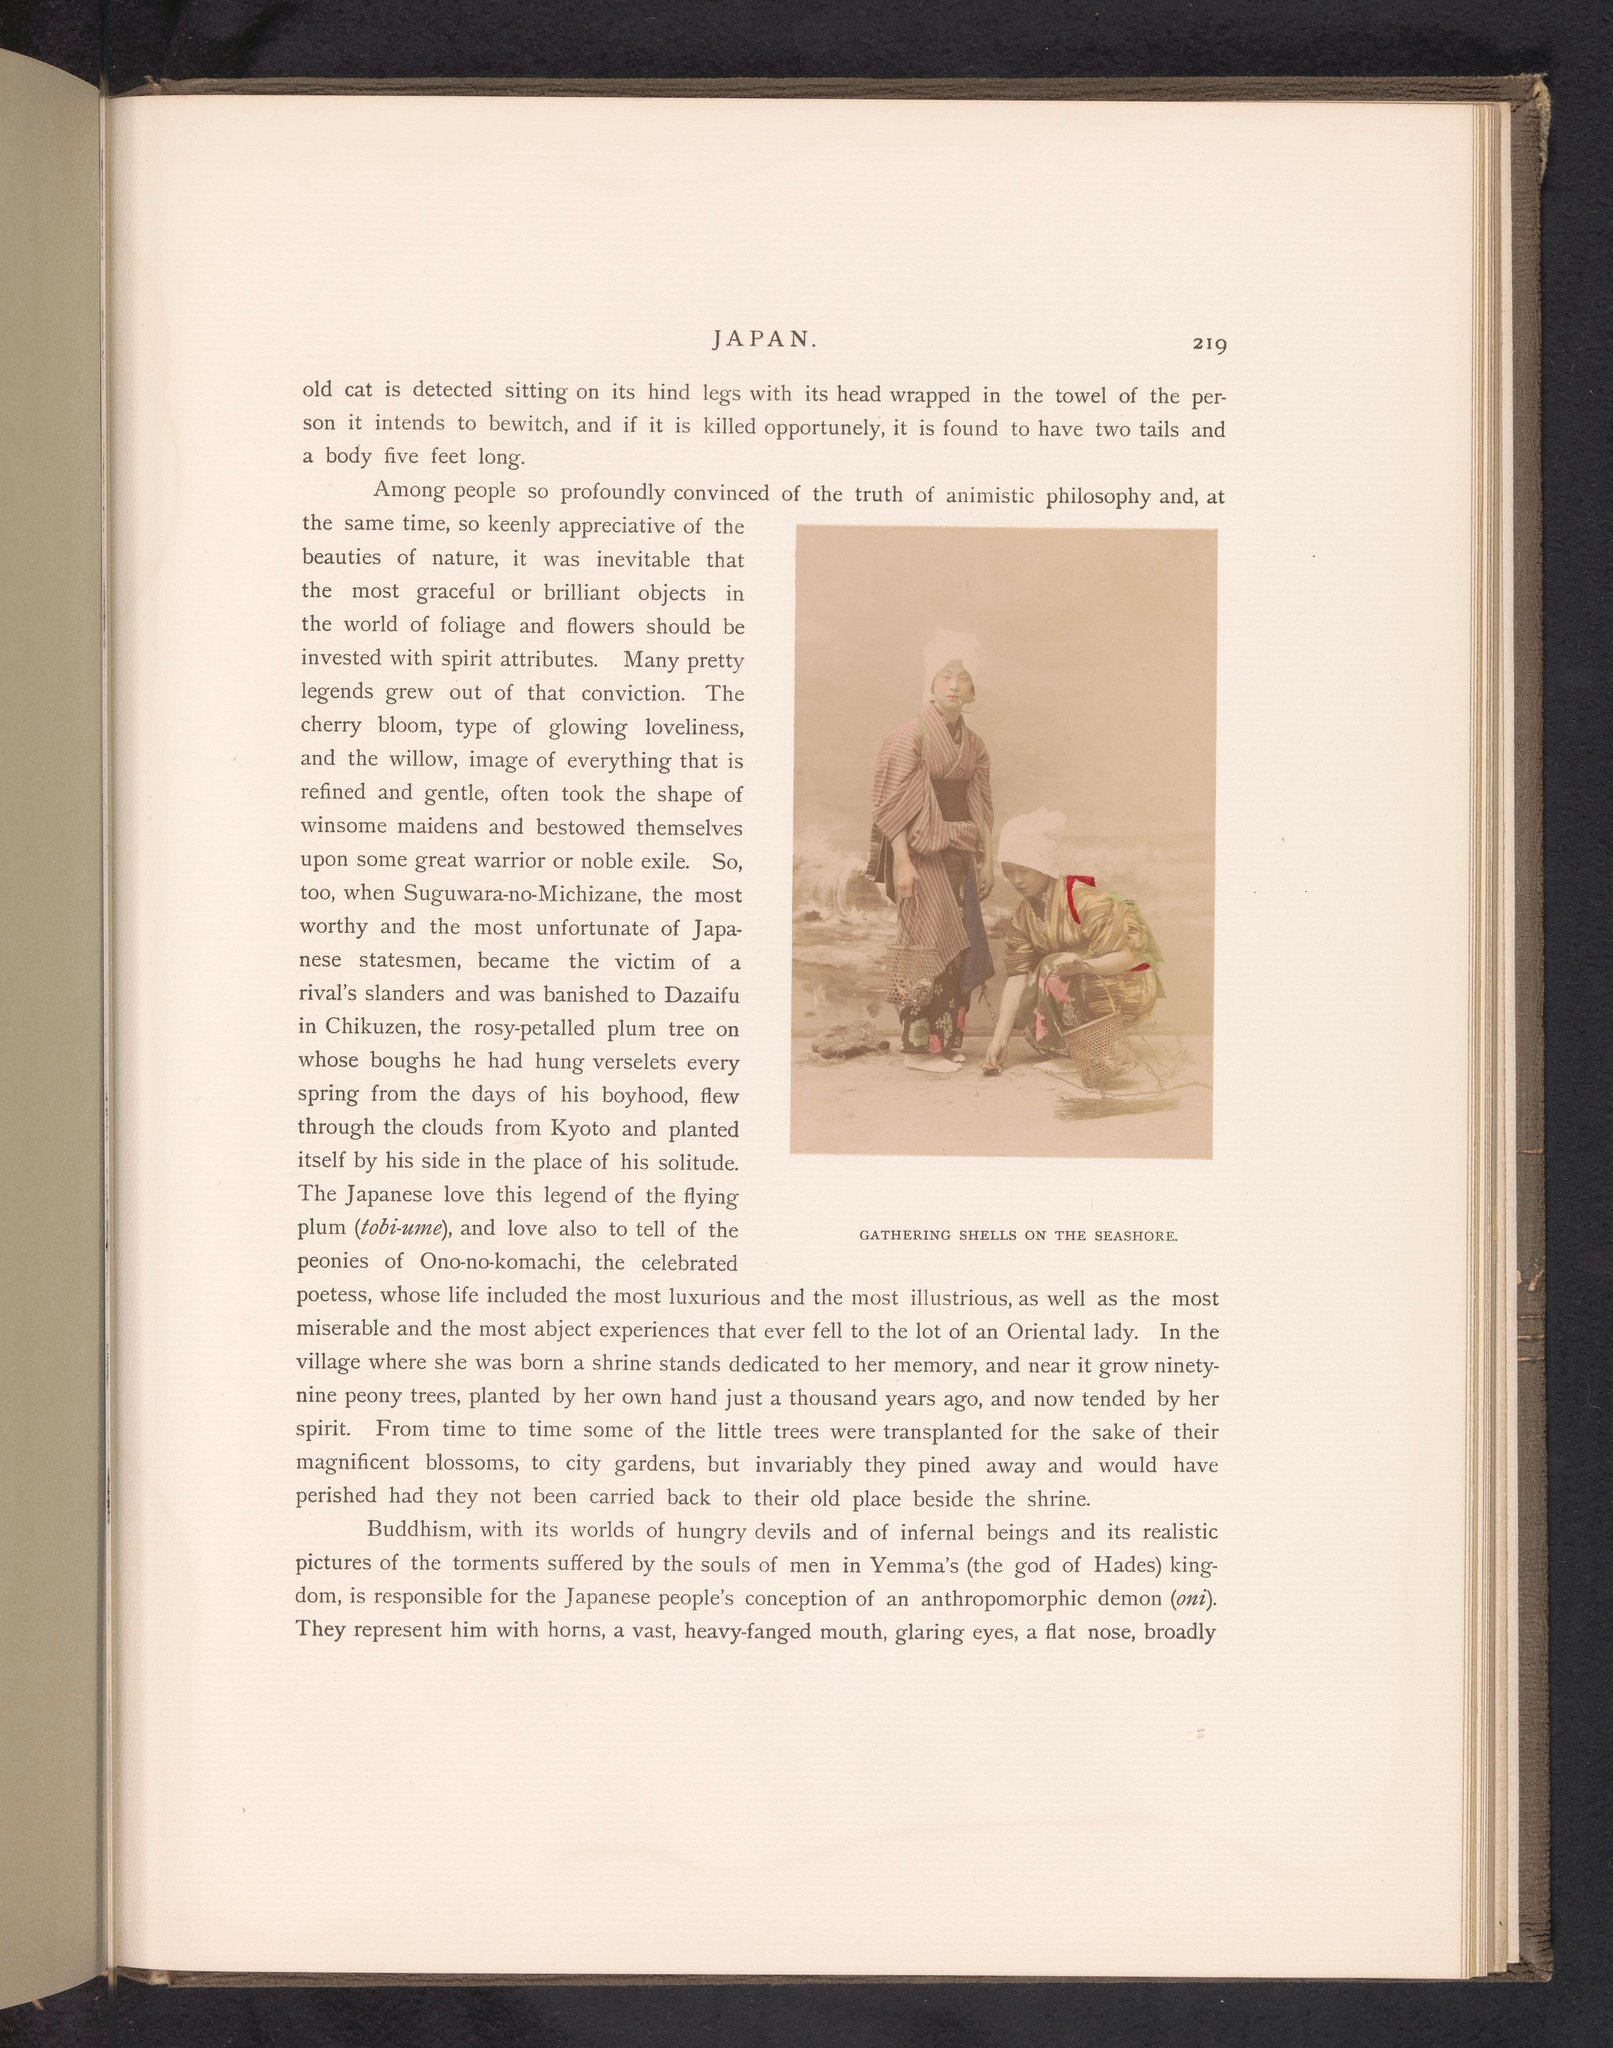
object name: page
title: Gathering shells on the seashore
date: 1887-1897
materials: photographic support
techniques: albumen print, hand coloring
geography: japan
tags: shell fishery, child (at home) - aa - girl, beach